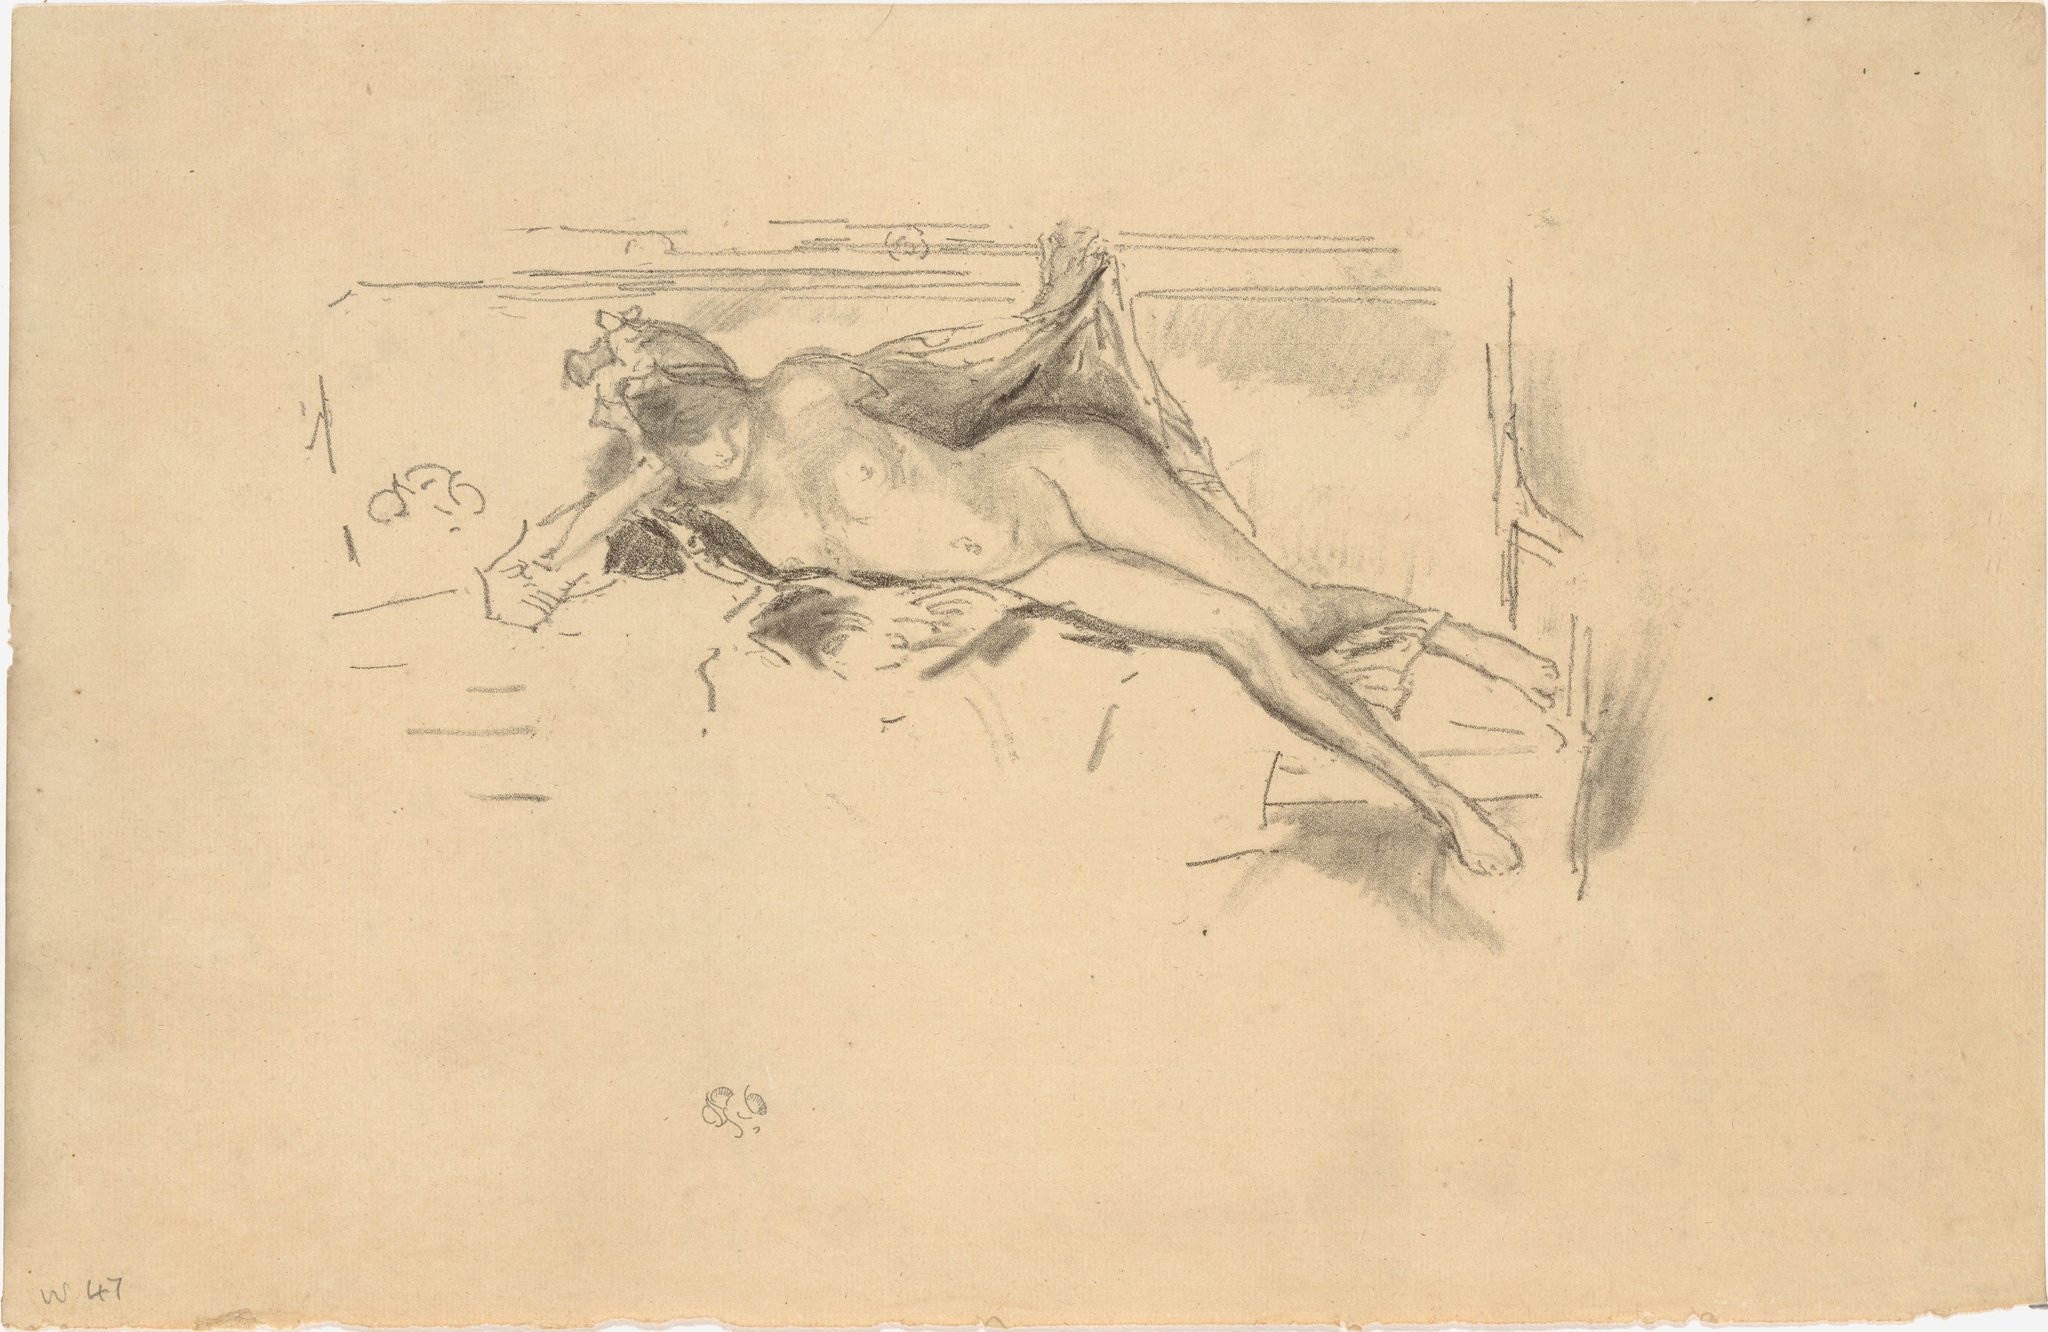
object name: print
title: Nude Model Reclining (Nude Model Resting)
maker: james mcneill whistler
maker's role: artist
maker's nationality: american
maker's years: 1834-1903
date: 1893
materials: ink, paper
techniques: printing, stumping, lithography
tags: female nudes